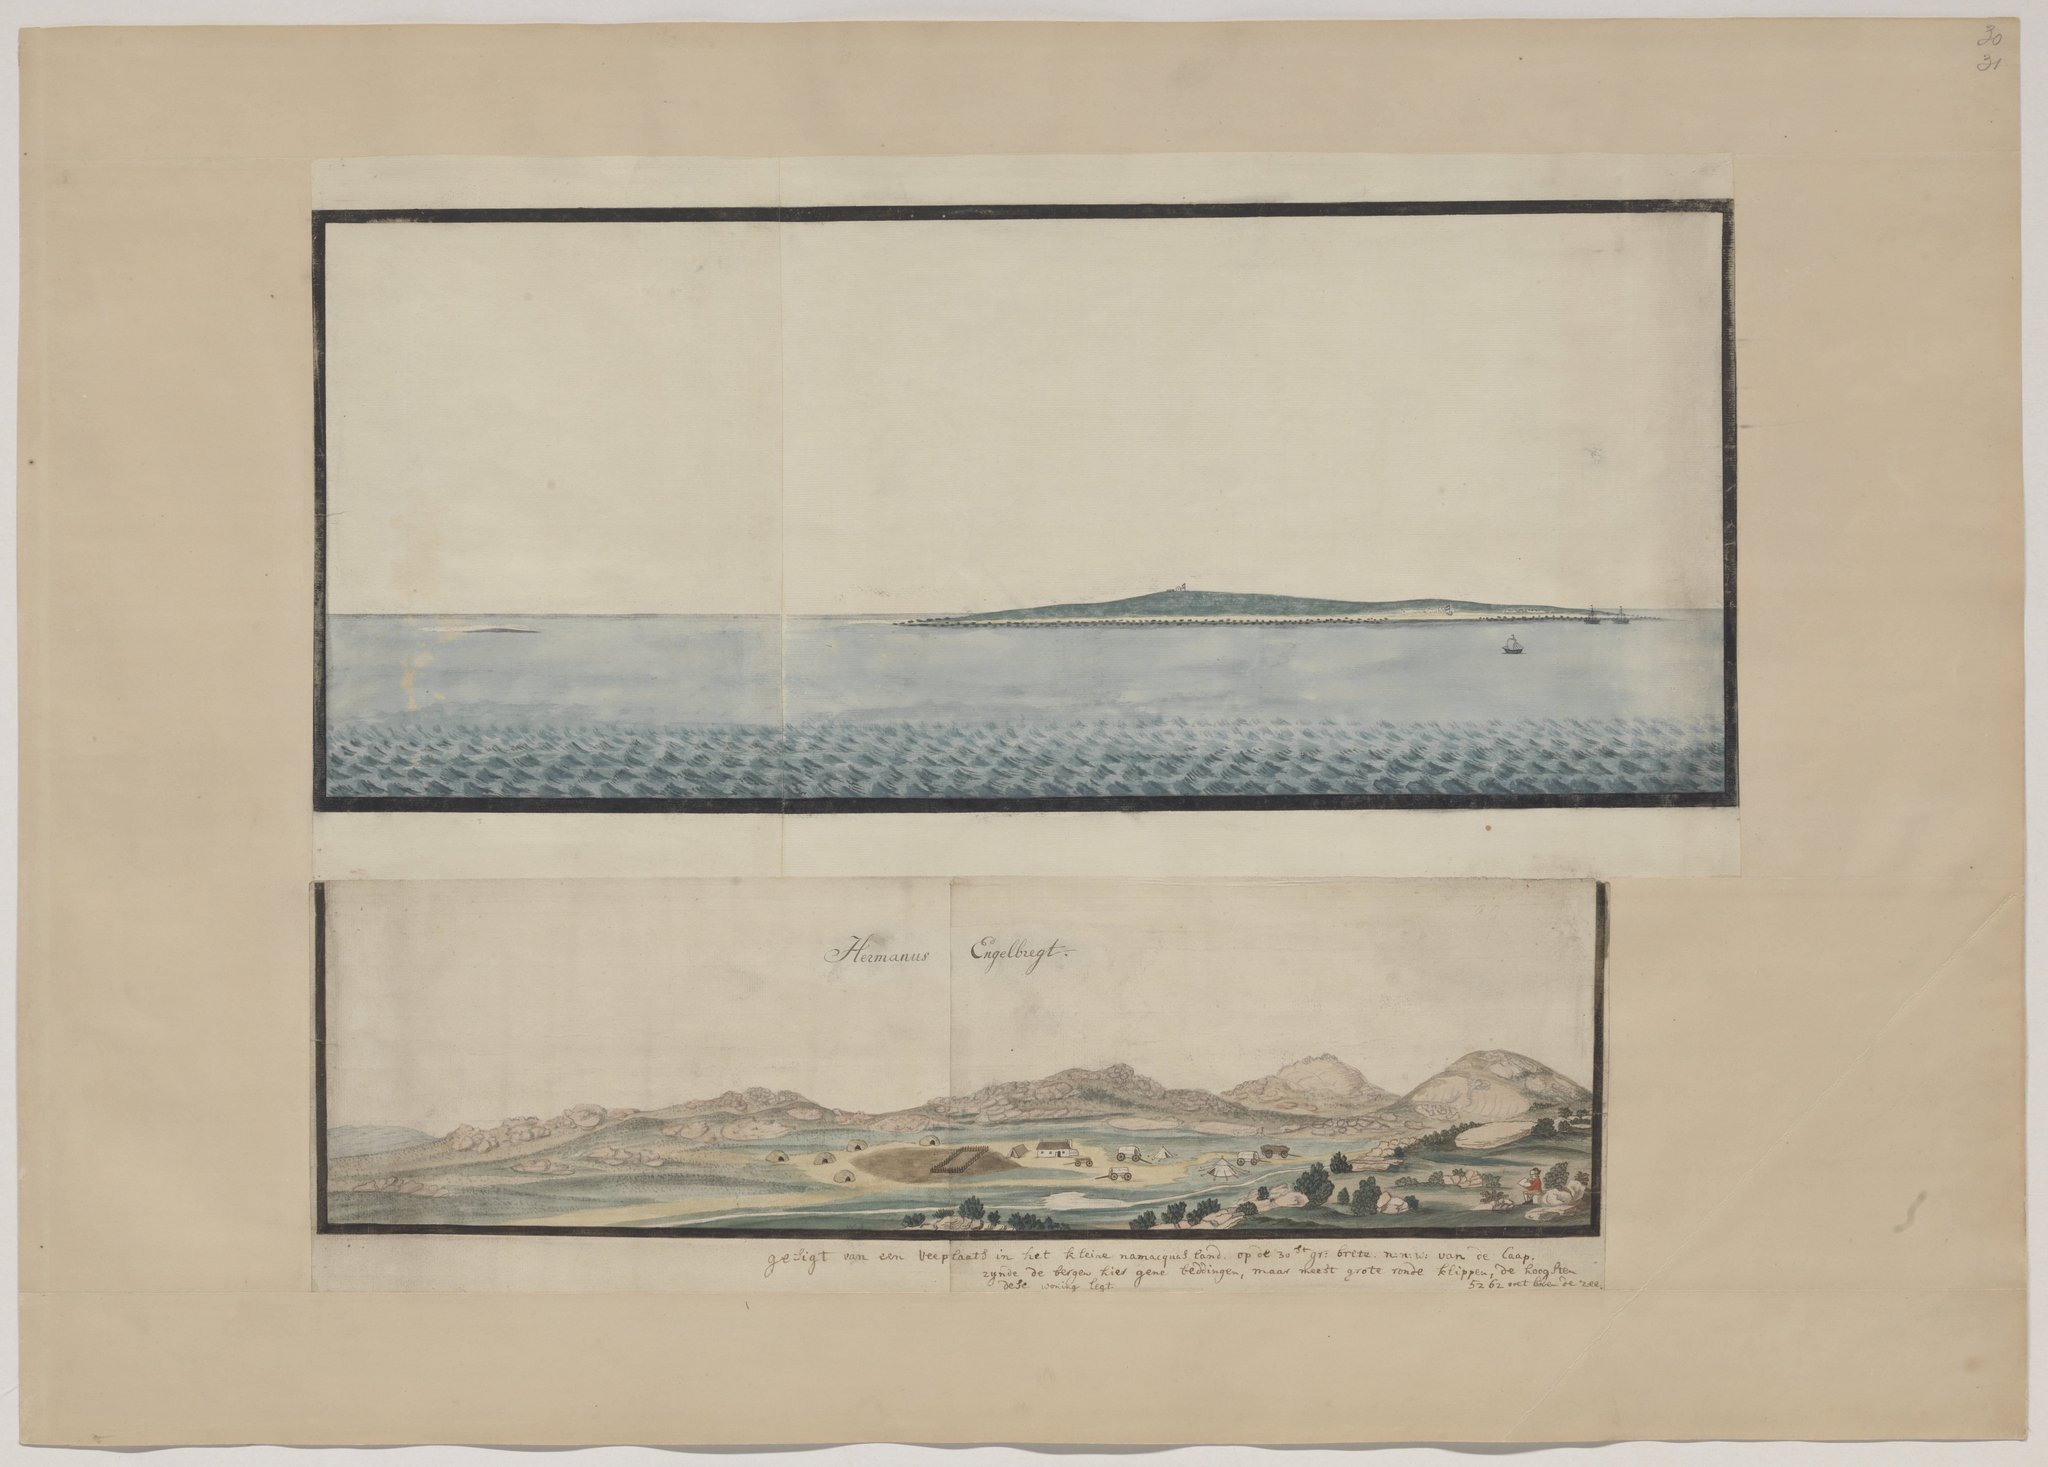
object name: topographical view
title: Stock farm of Hermanus Engelbrecht, near the Kamiesbergen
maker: robert jacob gordon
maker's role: draughtsman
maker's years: 1743-1795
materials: ink, paper, pencil, watercolor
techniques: brush, pen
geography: cape province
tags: draughtsman, robert jacob gordon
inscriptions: annotation: ‘linksboven: Hermanus Engelbregt; onderaan: zie De Jong’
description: Oorspronkelijk in omslag van roodkleurig halfleer en roodgemarmerd plat, dorso met ribben en goudopdruk; 71 x 99 x 6 cm.